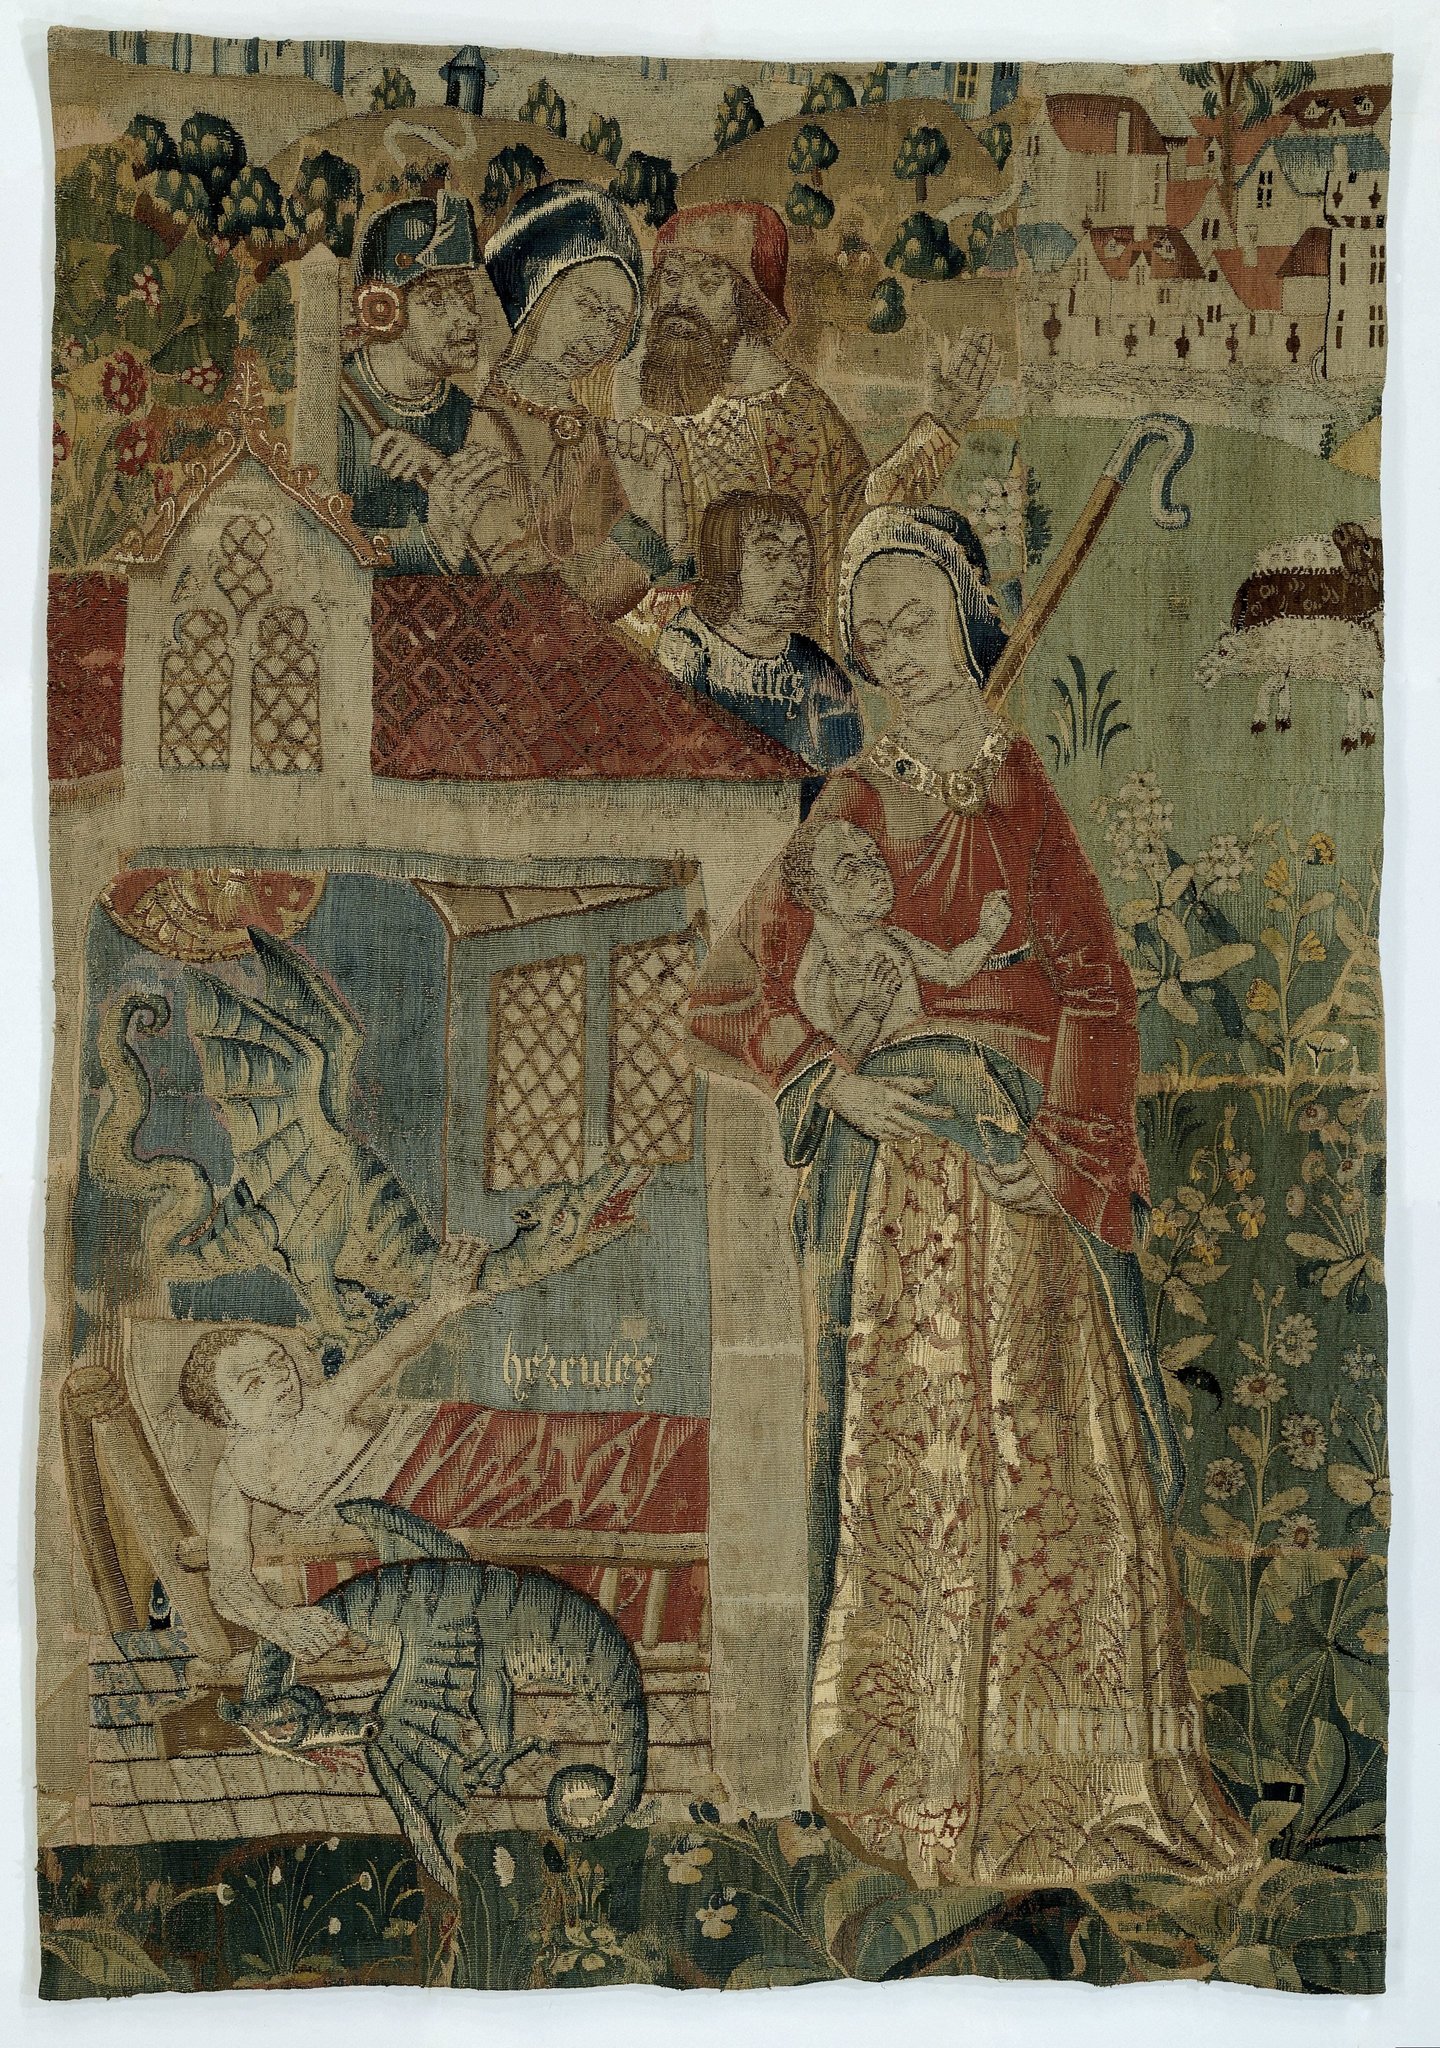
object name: tapestry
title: De geschiedenis van Hercules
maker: Anonymous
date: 1485-1505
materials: silk, wool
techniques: tapestry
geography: southern netherlands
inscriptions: : ‘ALCUMENA’, : ‘HERCULES’, : ‘HERCULES’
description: Tapestry (fragment). The Childhood of Hercules: Hercules Strangling Two Serpents. Wool, silk. Tournai or Brussels, c. 1485 - 1500.